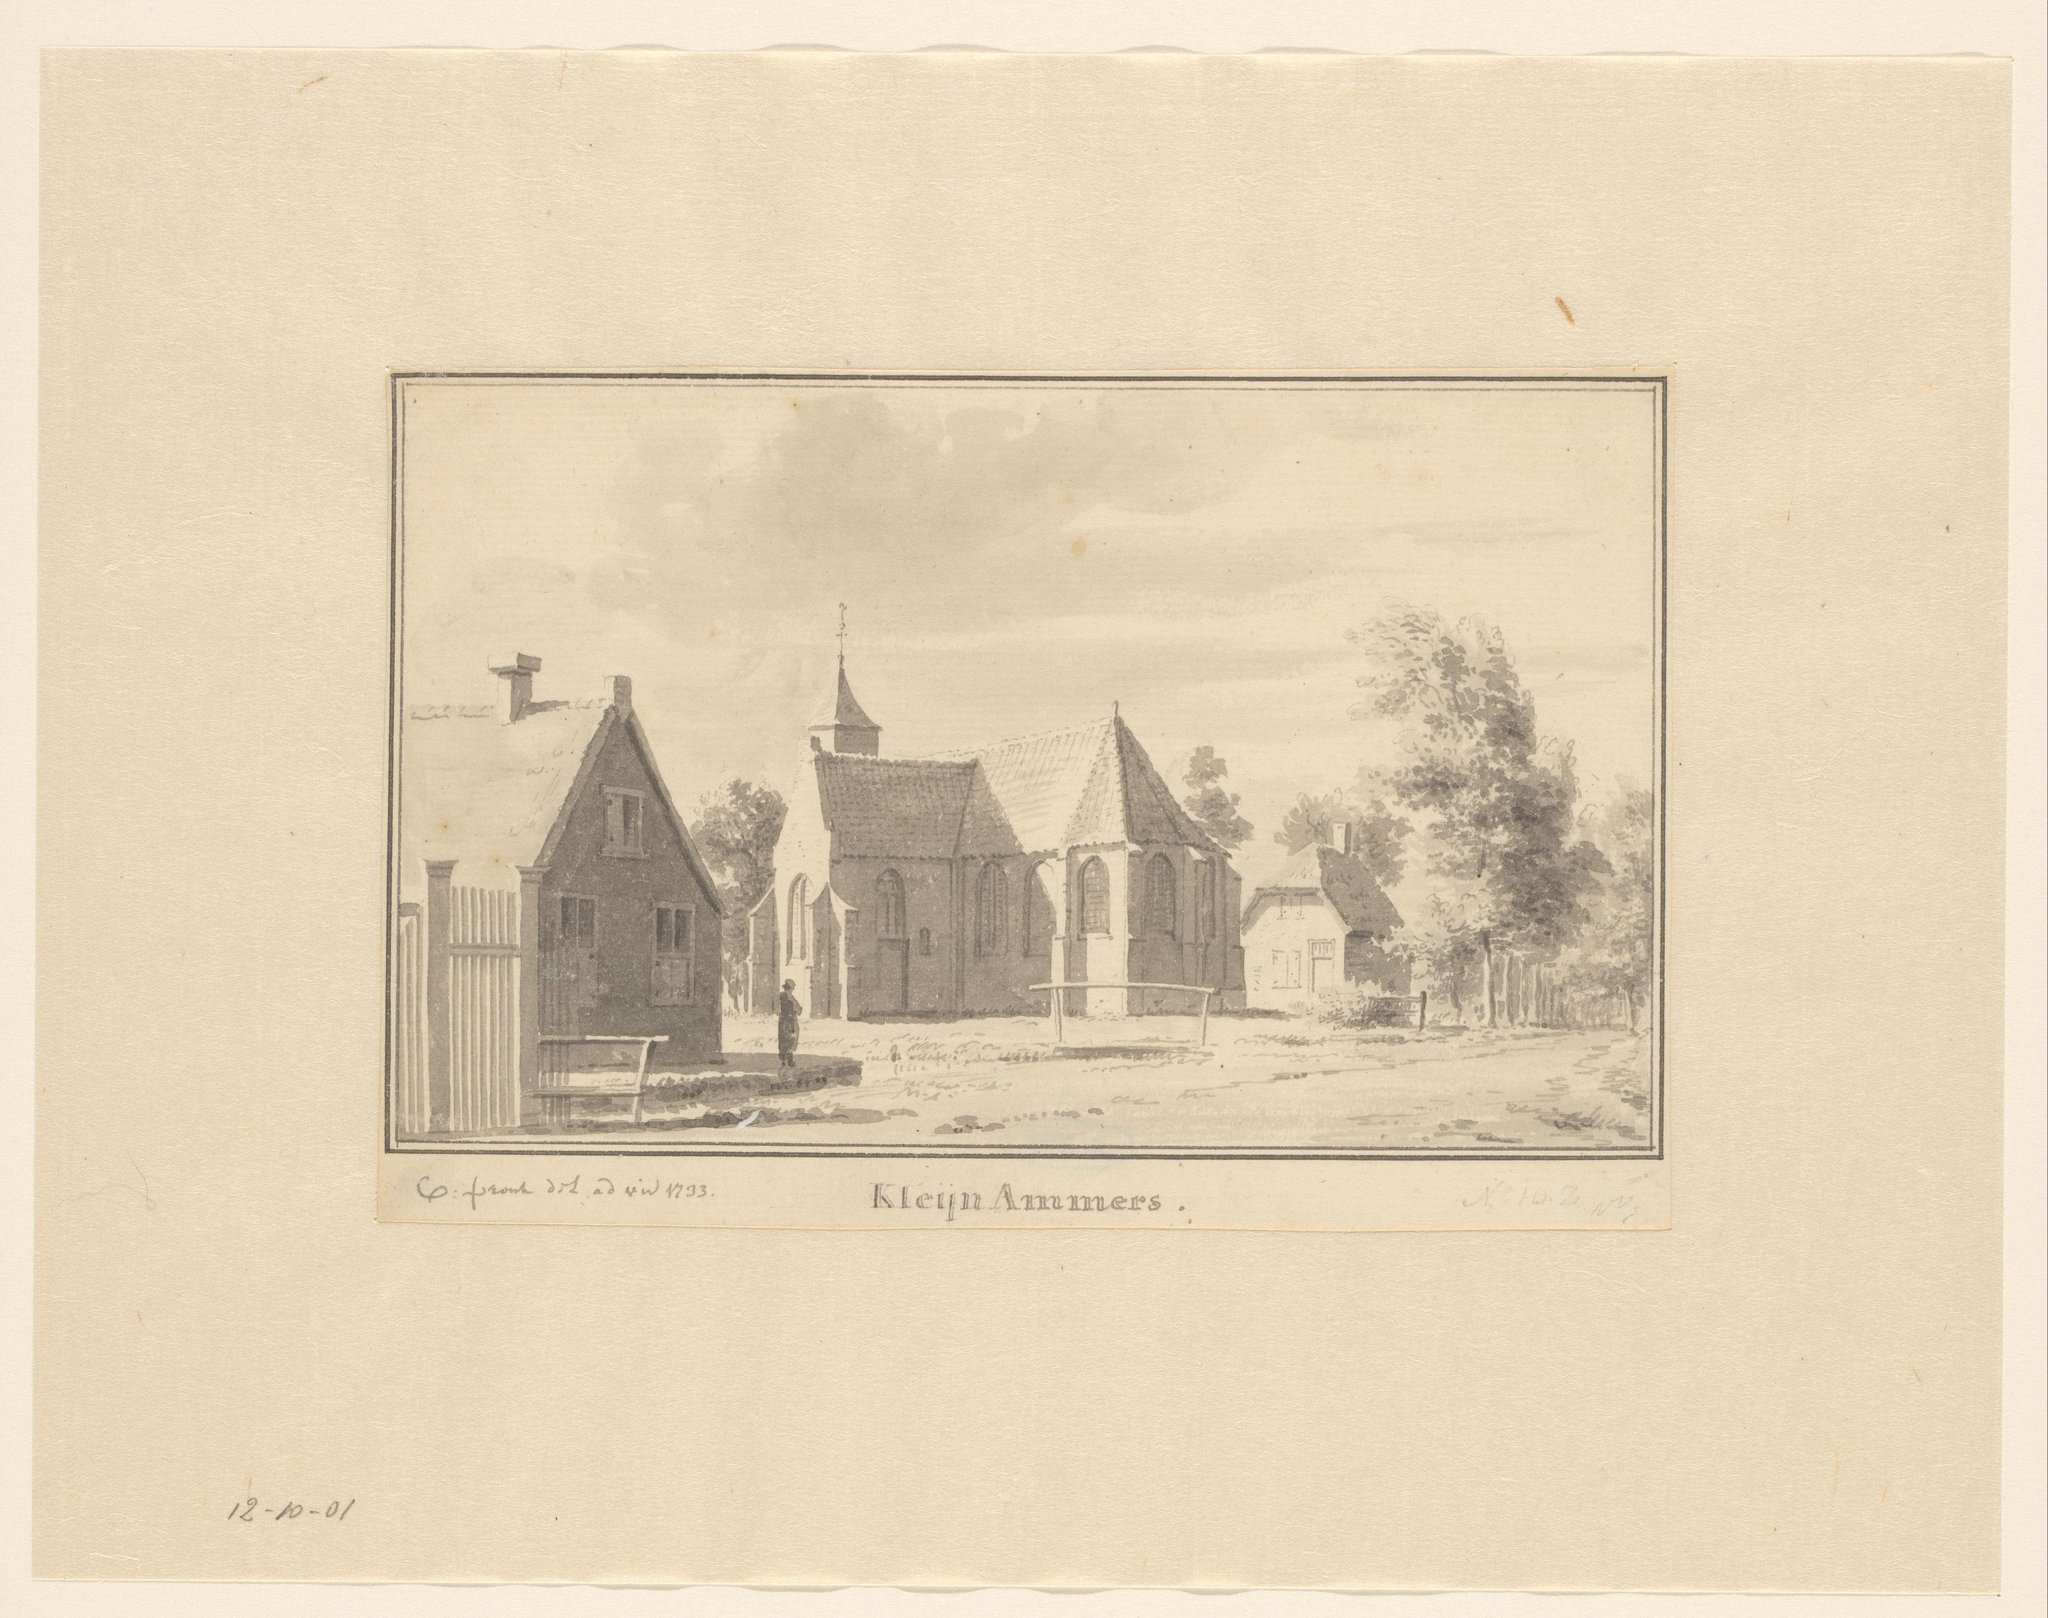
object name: drawing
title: De kerk in Ammerstol of Klein Ammers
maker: cornelis pronk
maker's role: draughtsman, painter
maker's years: 1691-1759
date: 1733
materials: ink, paper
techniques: brush, pen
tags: village street, church (exterior)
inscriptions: inscription: ‘C: pronk del ad viv 1733 / Kleijn Ammers.’